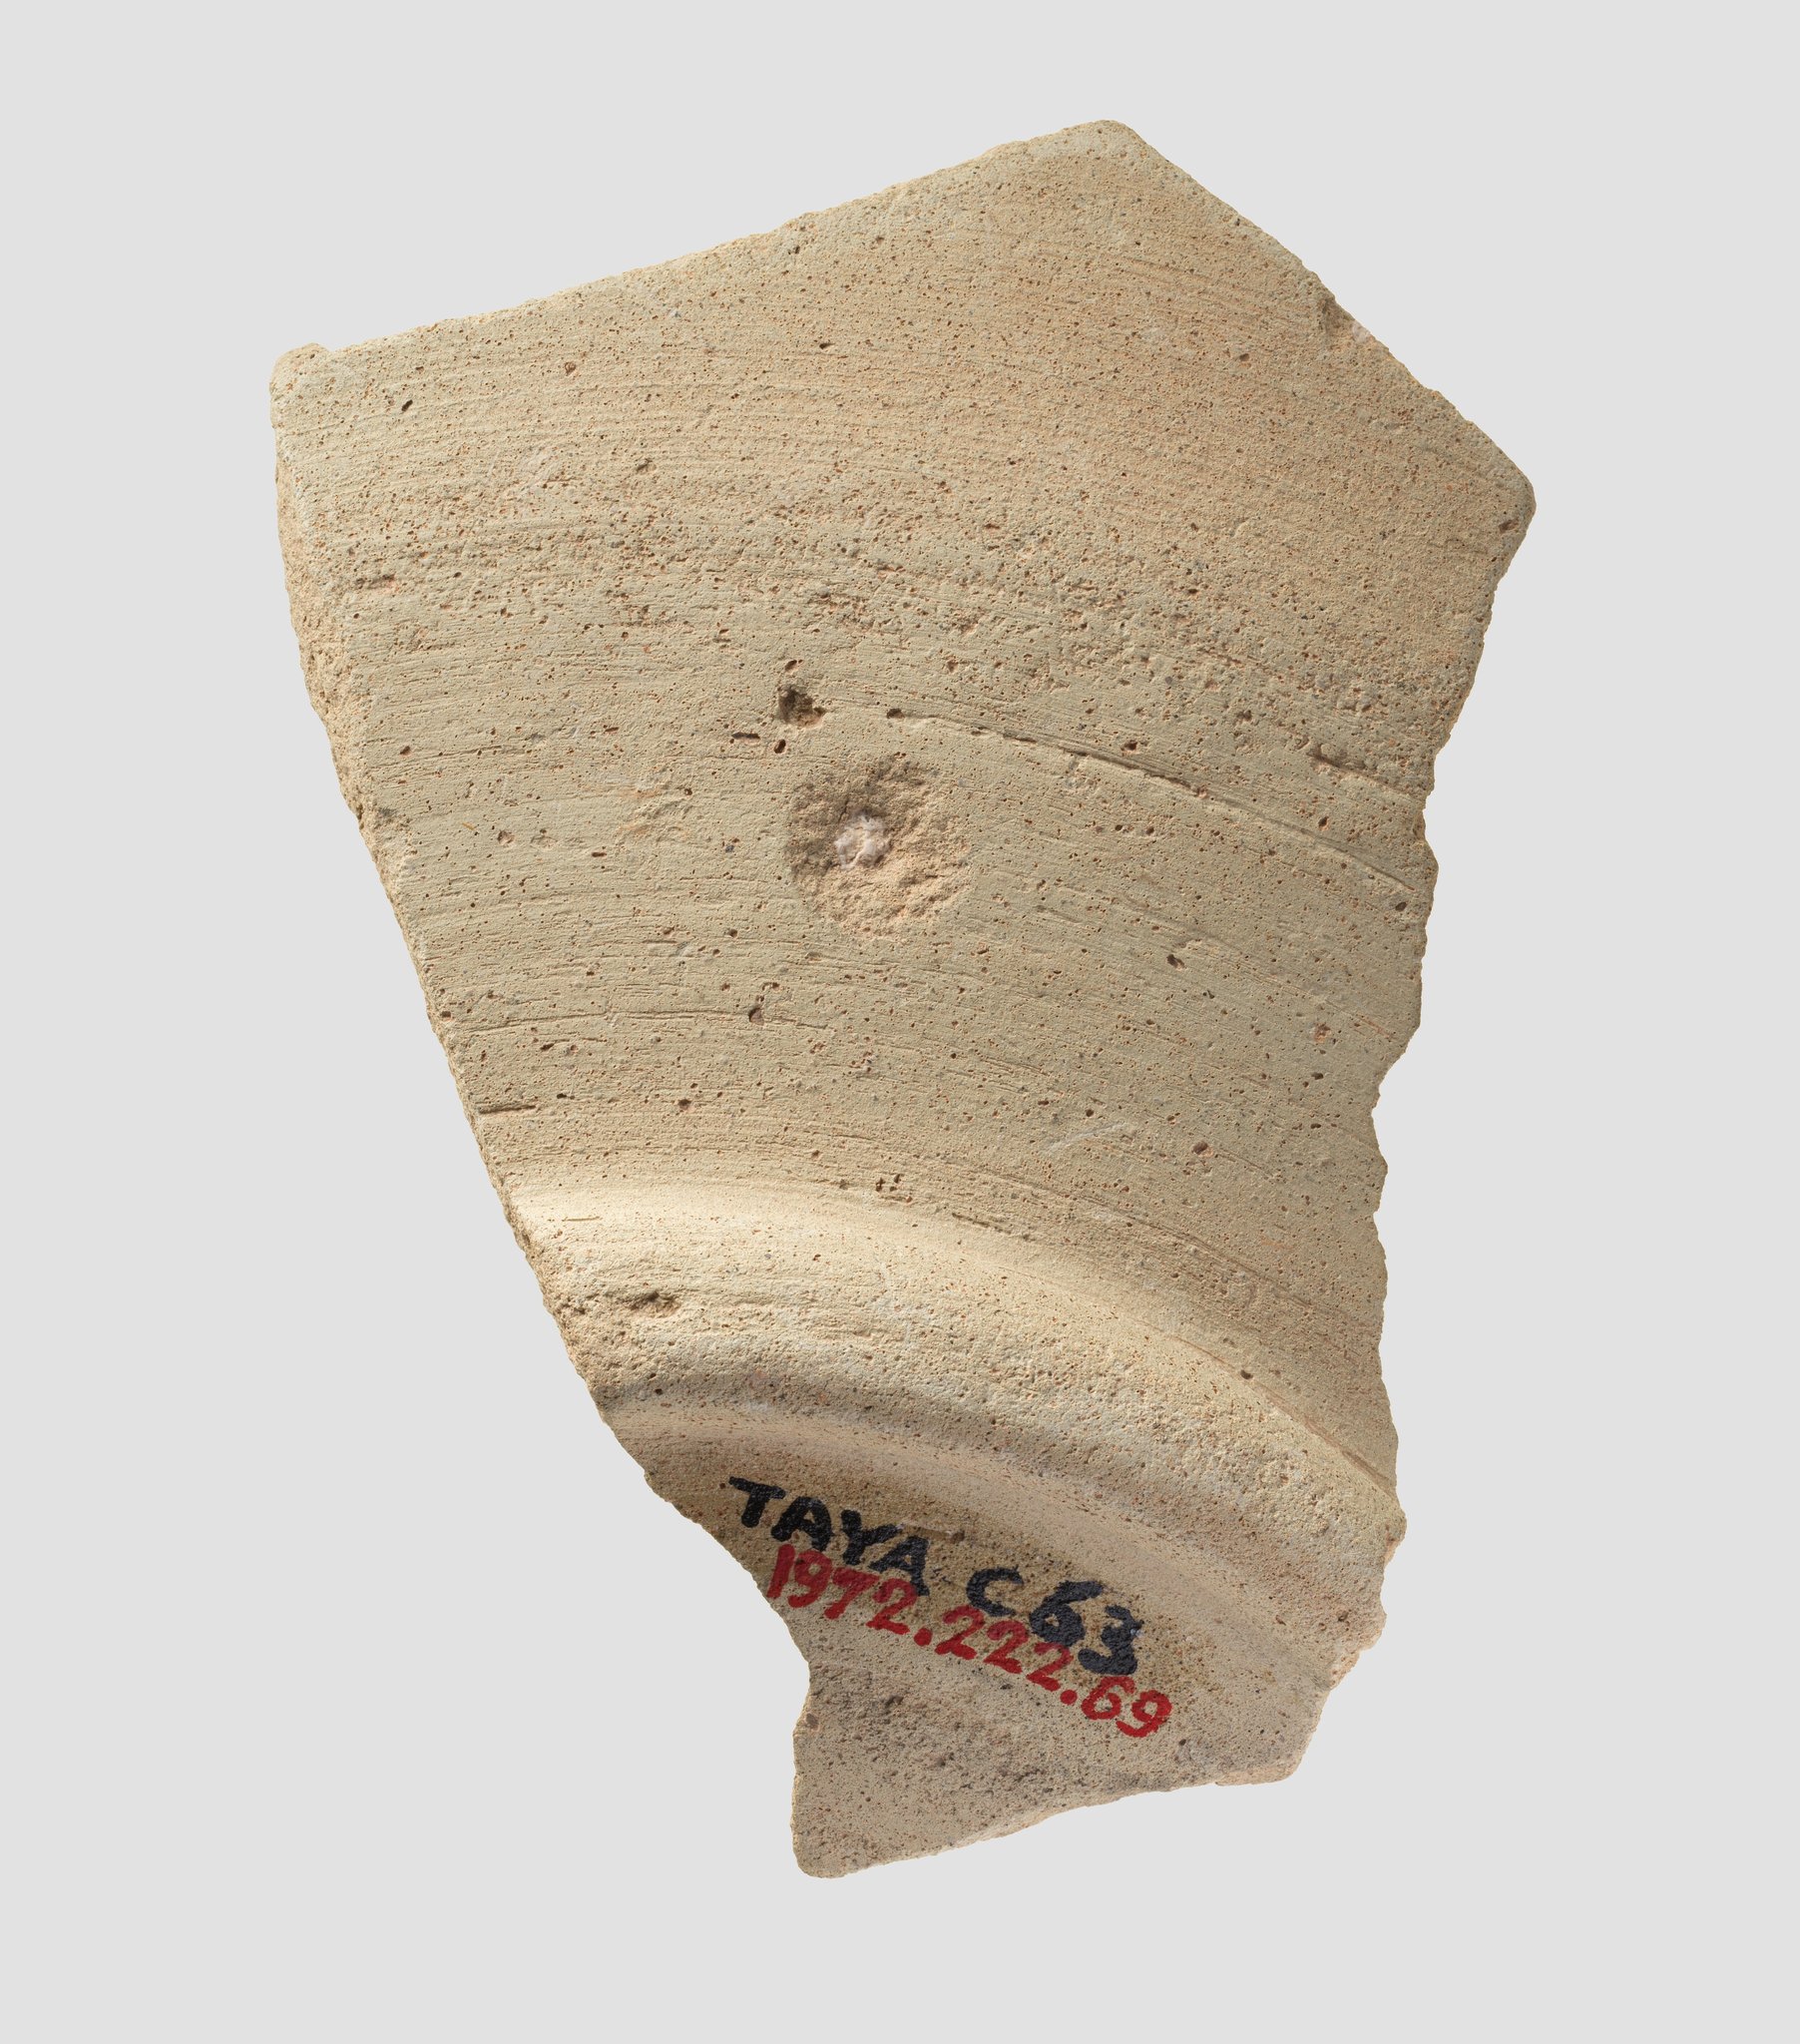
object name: sherd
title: Ring base sherd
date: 2000-1668 BCE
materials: ceramic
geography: mesopotamia